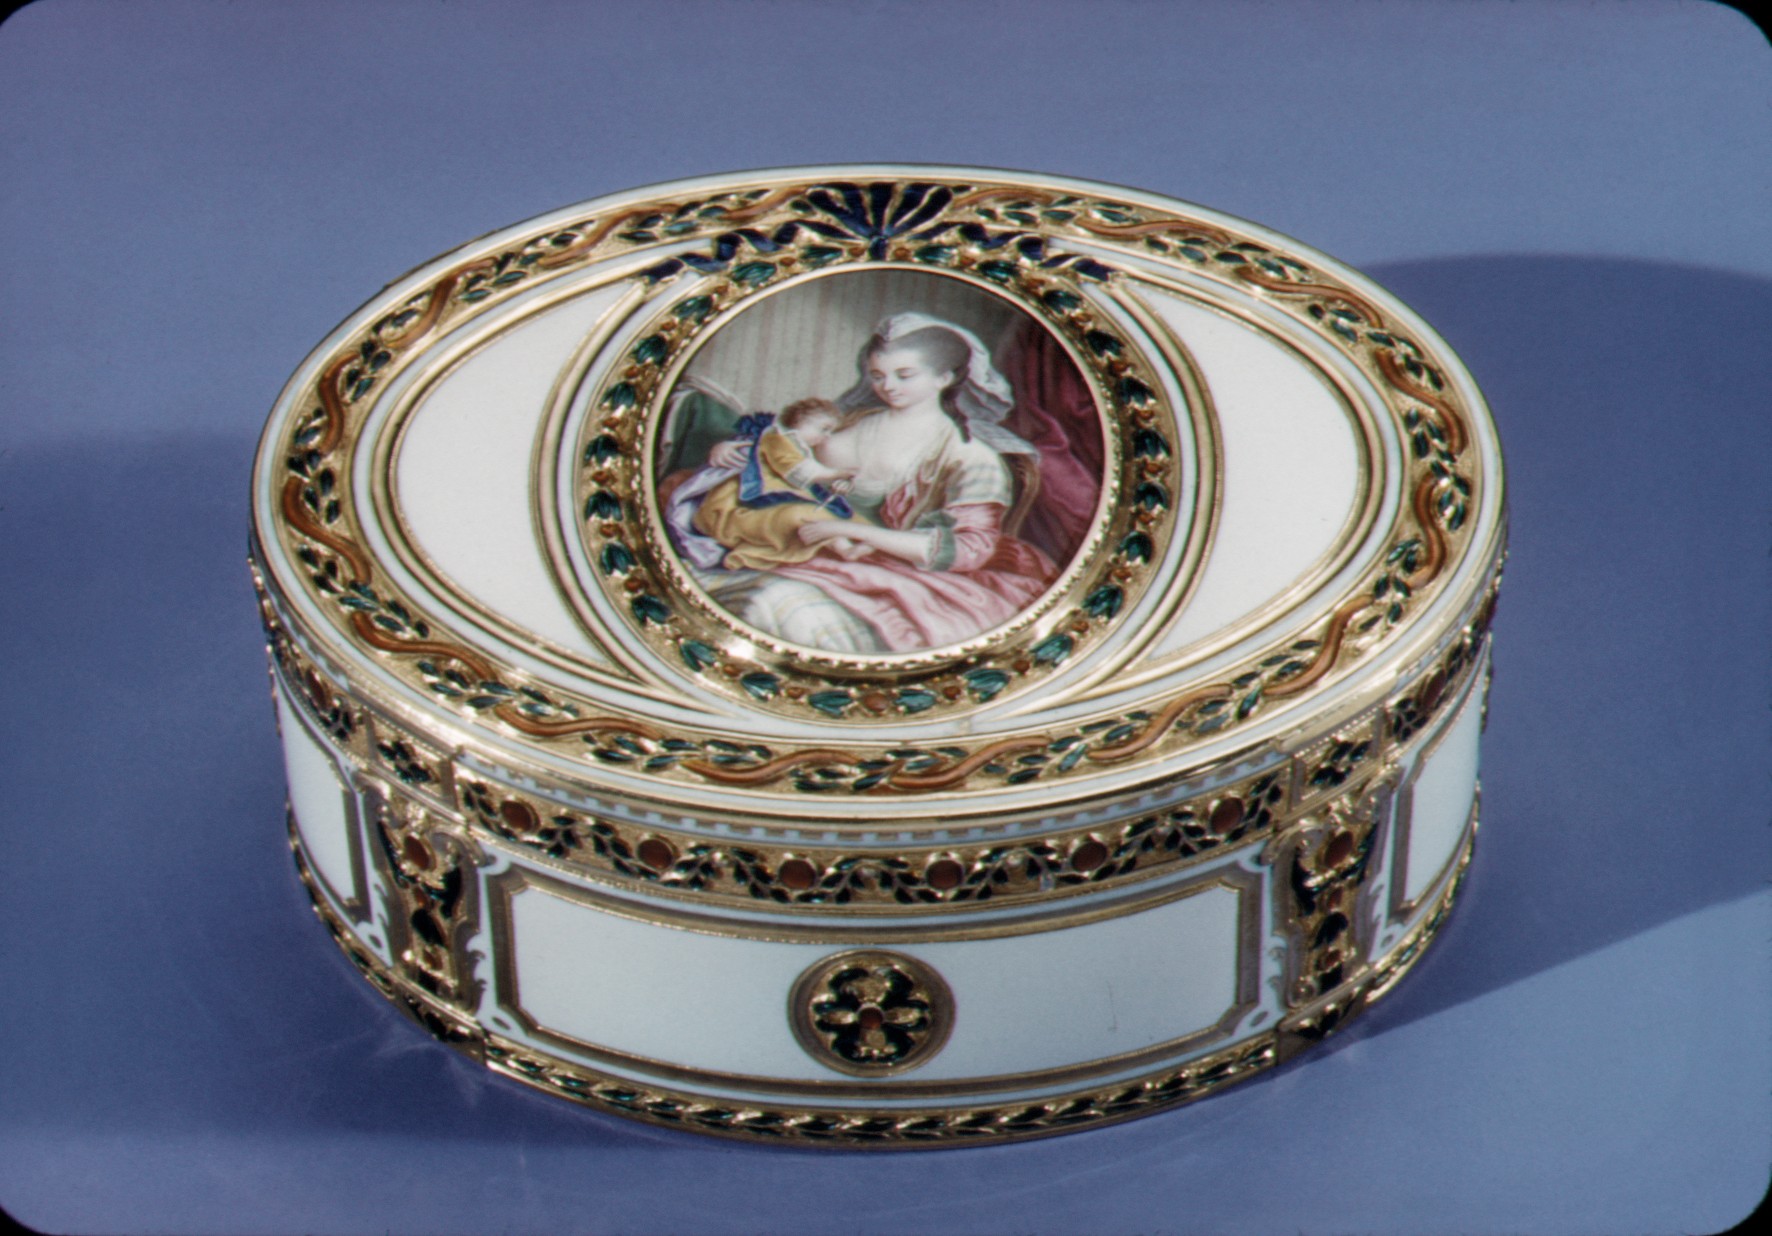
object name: snuffbox, painting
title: Snuffbox with miniature of a mother nursing a child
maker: joseph etienne blerzy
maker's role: maker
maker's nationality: french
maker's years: 1750-1806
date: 1775-1776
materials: enamel, gold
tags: infants,mothers